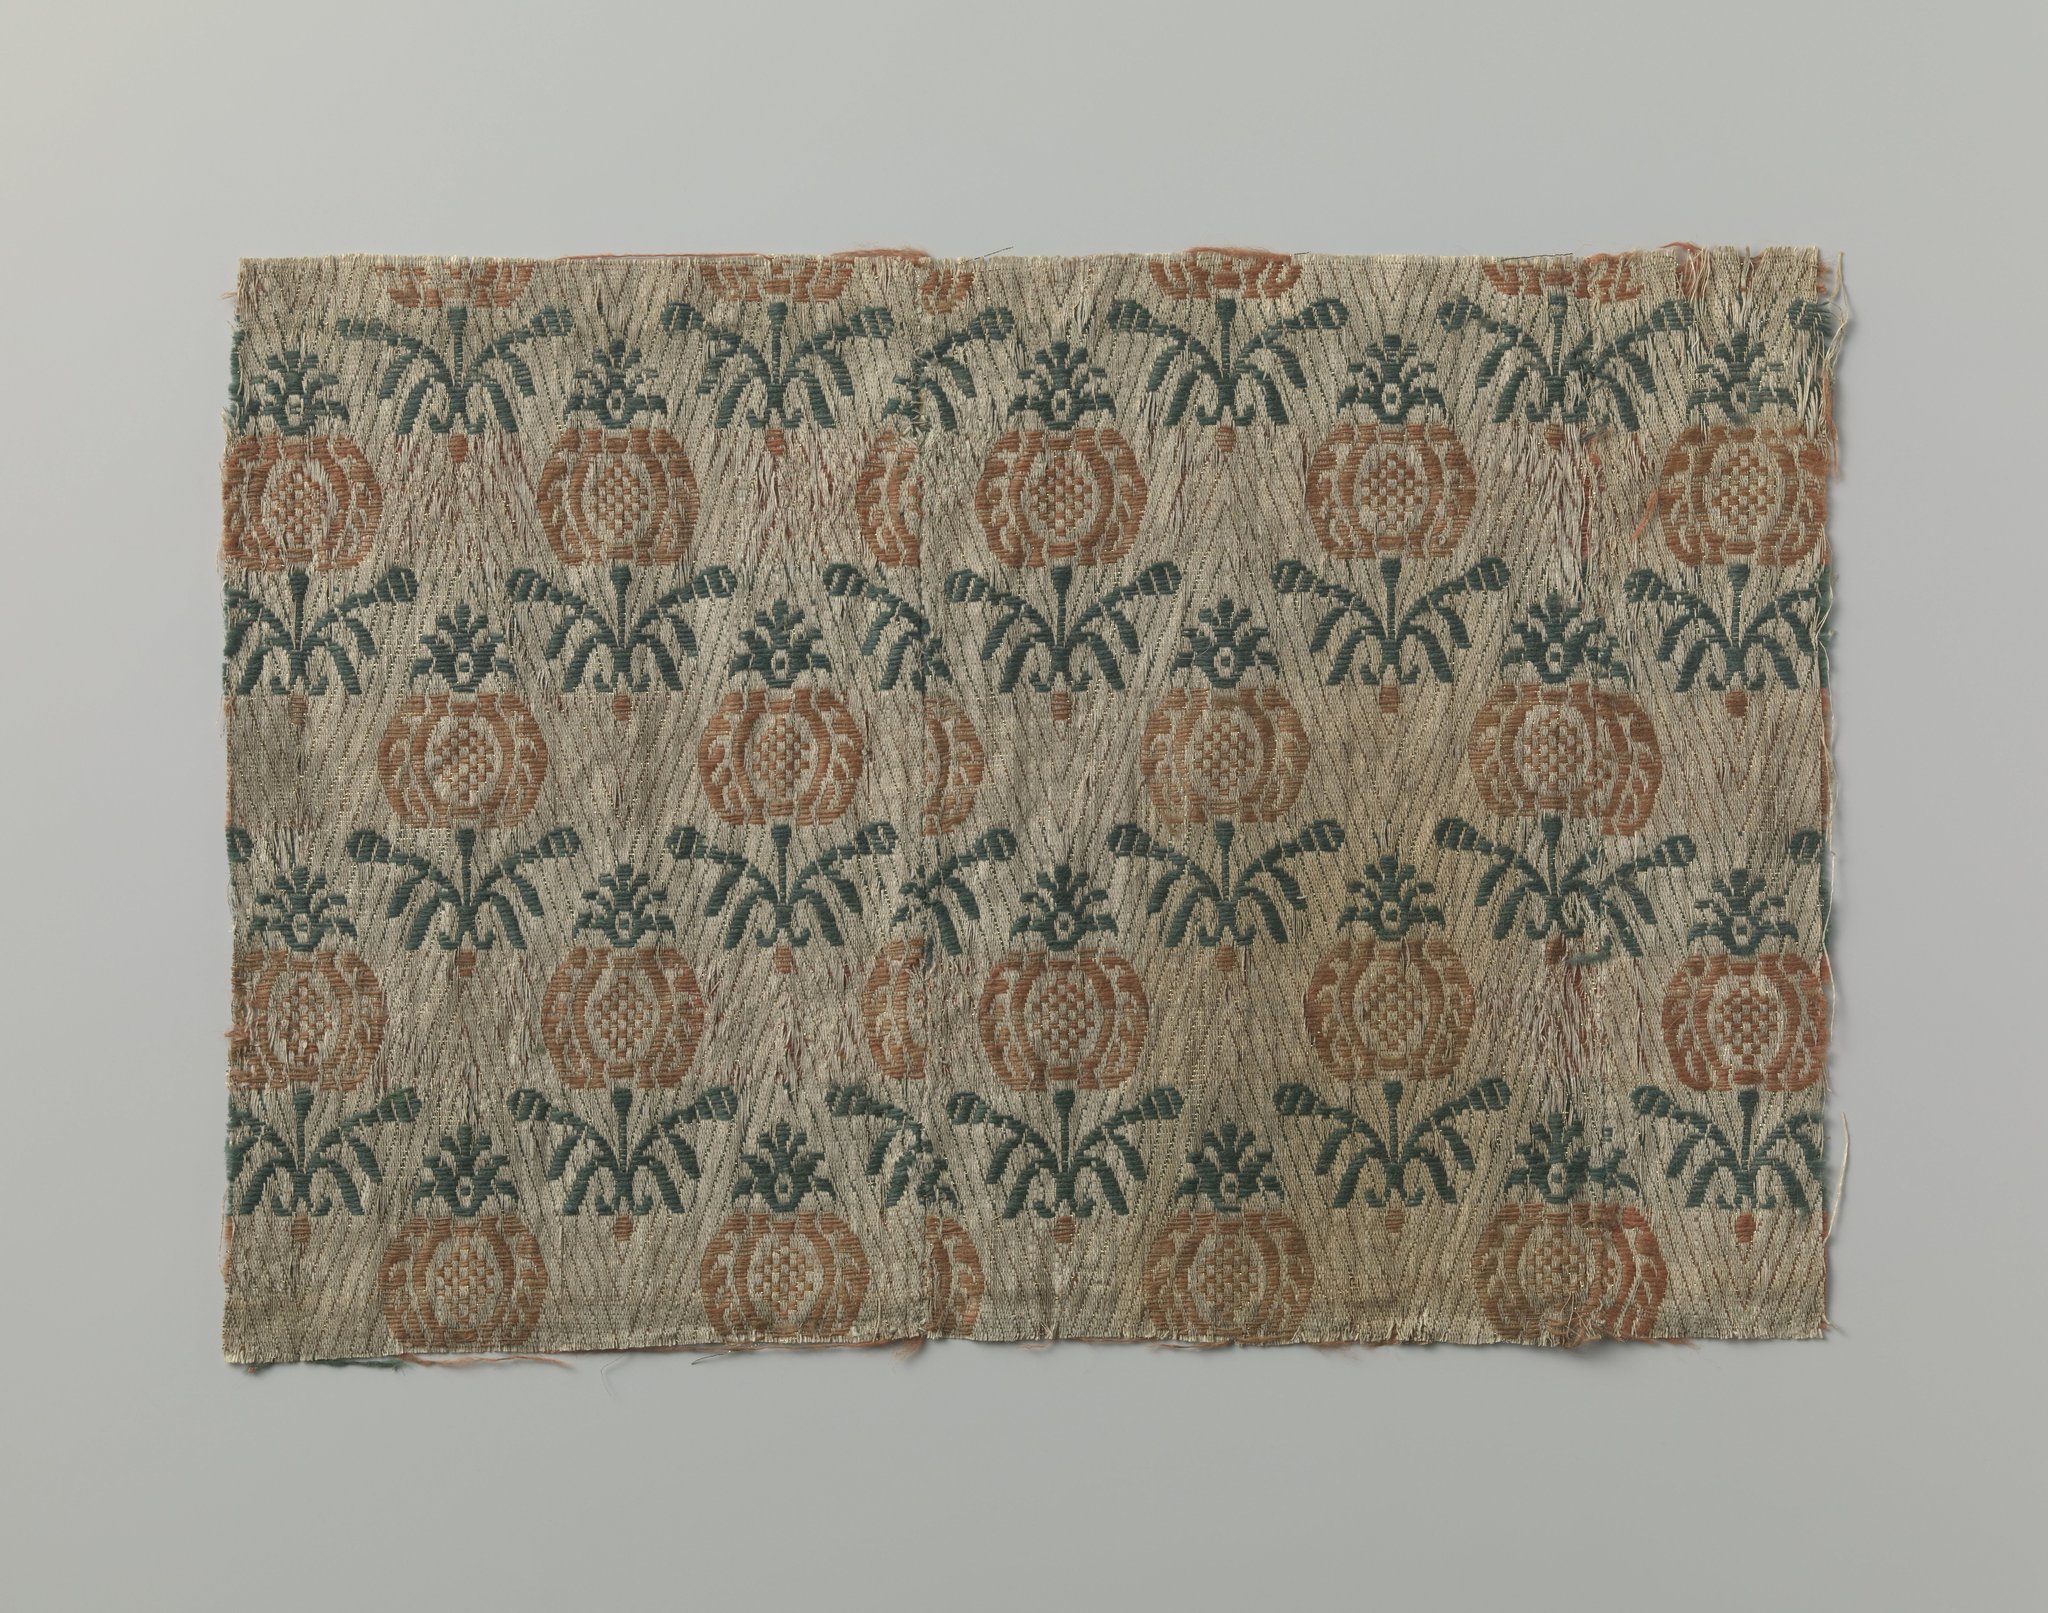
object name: woven material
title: Fragment van een weefsel in linnen en wol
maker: Anonymous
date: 1550-1599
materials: linen, wool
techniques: weave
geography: italy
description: Fragment (3 aan elkaar genaaide stukken) met op écru fond horizontale rijen gestileerde bloemen in oranje en groen.